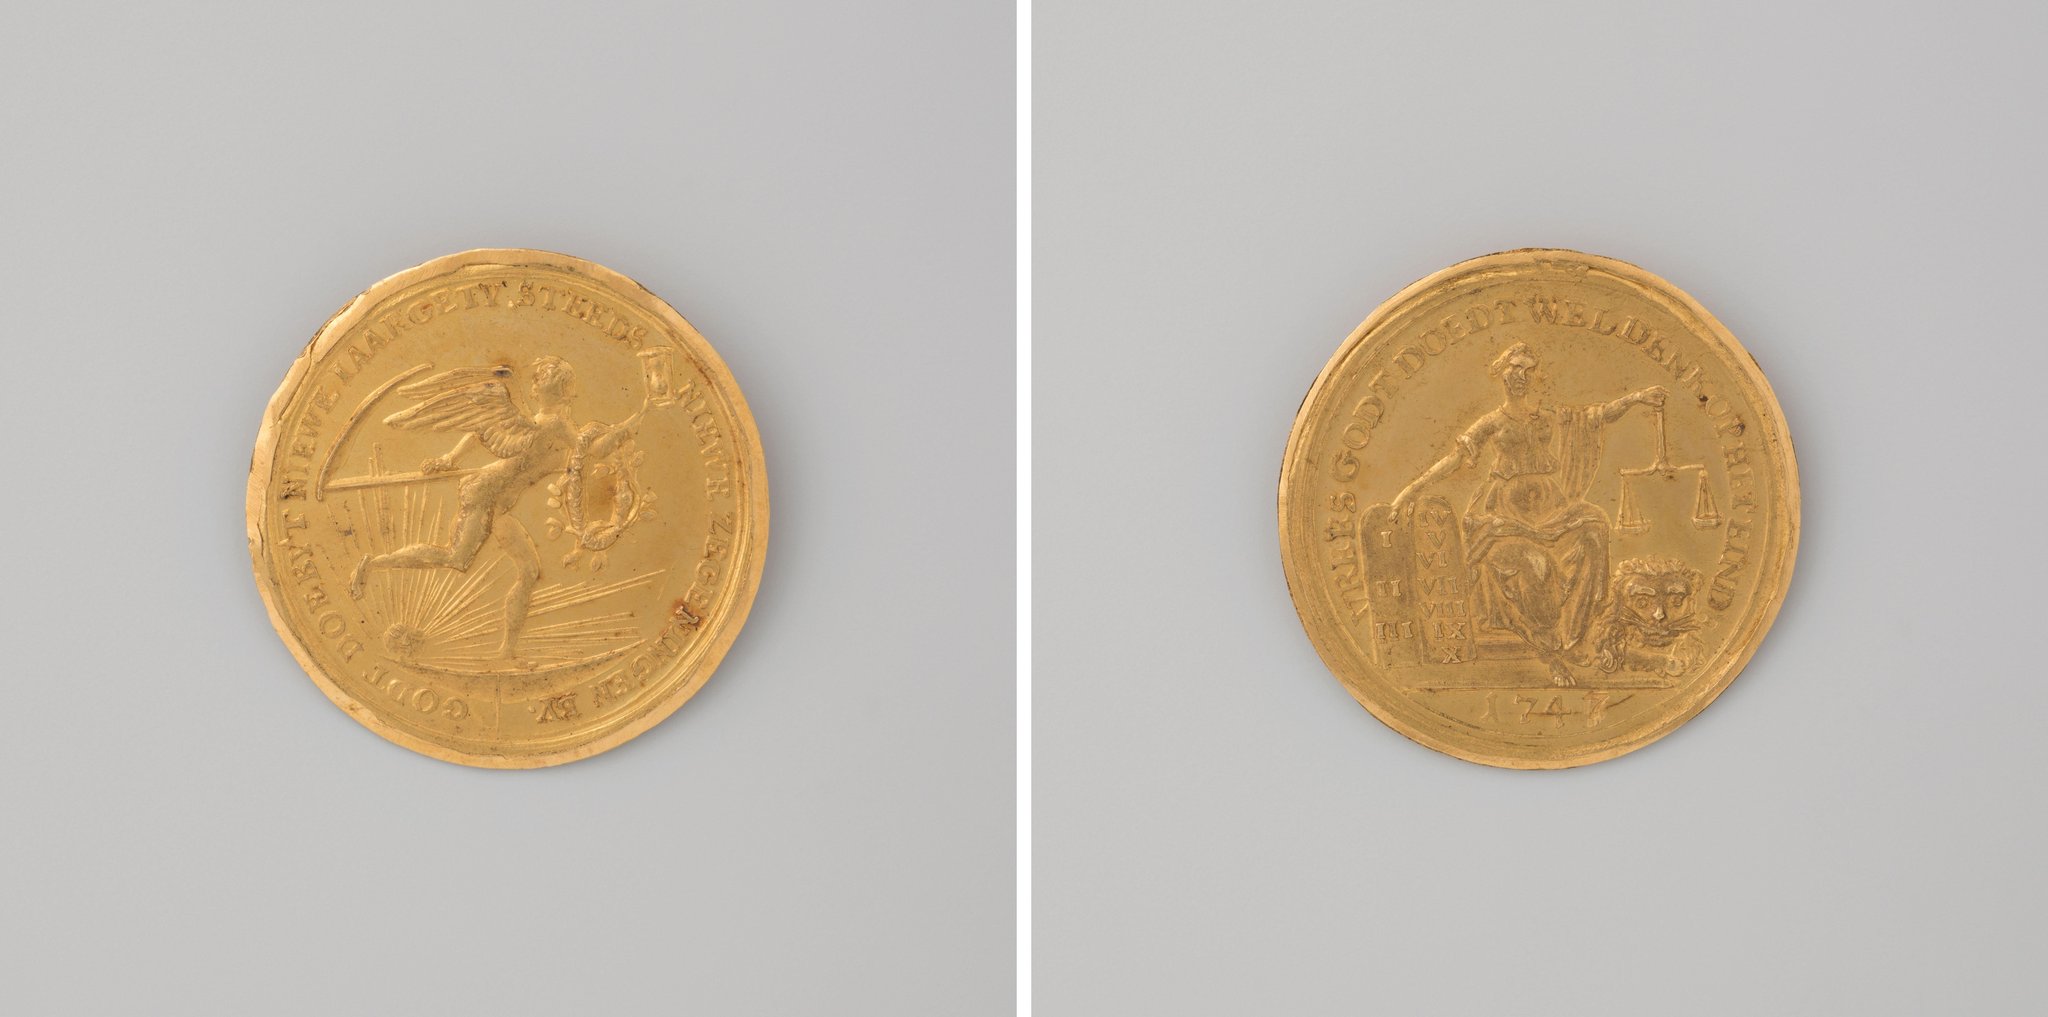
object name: new year medal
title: Aanvang van het jaar 1747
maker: martinus holtzhey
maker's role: medailleur, muntmaker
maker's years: 1697-1764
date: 1746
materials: gold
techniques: engraving, striking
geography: amsterdam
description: Gouden penning. Voorzijde: Tijd met zandloper, zeis en slangerond omwonden met bladerloof, beschenen door opgaande zon binnen omschrift. Keerzijde: Nederlandse maagd, vergezeld door leeuw met pijlenbundel, houdt weegschaal en geopend boek in handen binnen omschrift; afsnede: jaartal